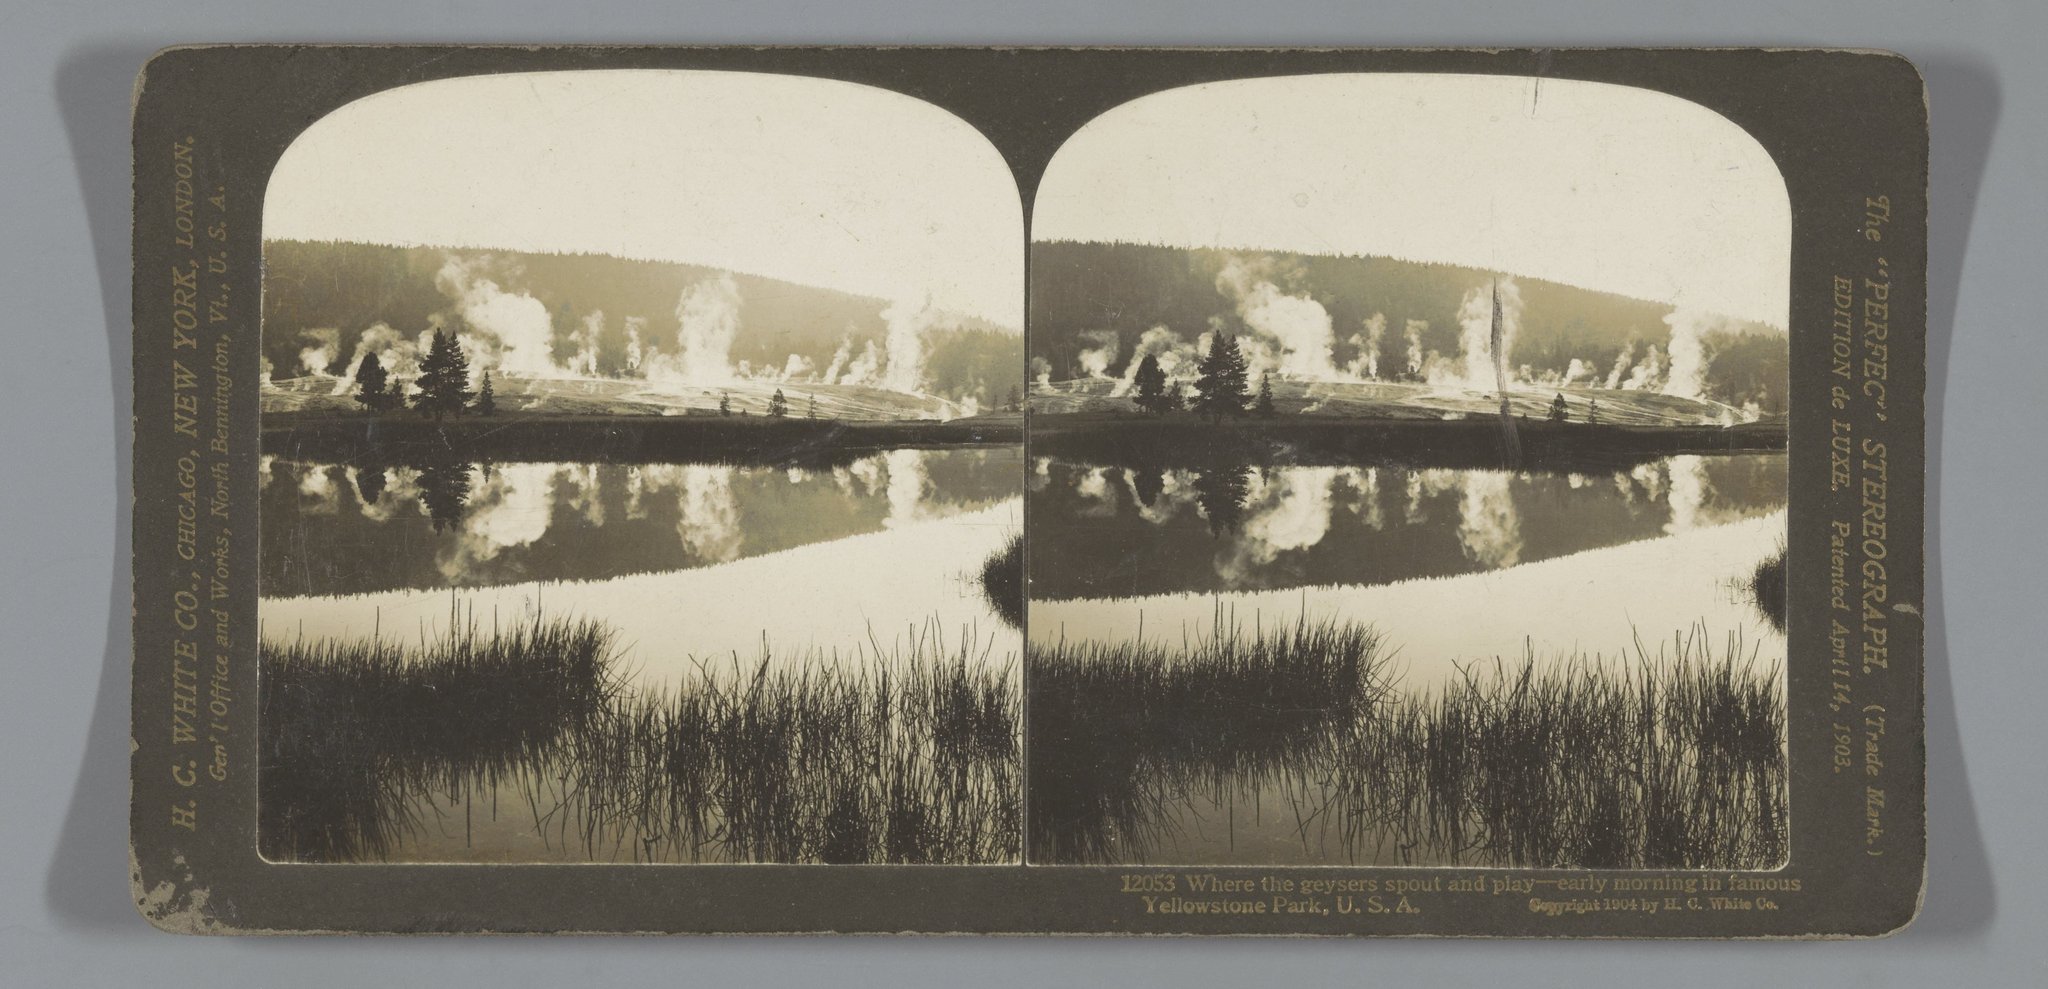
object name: stereograph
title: Where the geysers spout and play-early morning in famous Yellowstone Park, U.S.A.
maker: Anonymous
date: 1904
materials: paper, cardboard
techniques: gelatin silver print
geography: new york city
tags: hot spring, geyser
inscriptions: number: ‘12053’, inscription: ‘Upper Geyser Basin is one of the most popular places/ in the Park, only the Grand Canyon (...)’, inscription: ‘The " PERFEC" STEREOGRAPH. (Trade Mark.)/ EDITION de LUXE. Patented April 14, 1903.’, title: ‘Early morning in famous Yellowstone Park, U. S. A.’, copyright notice: ‘Copyright 1904 by H. C. White Co.’